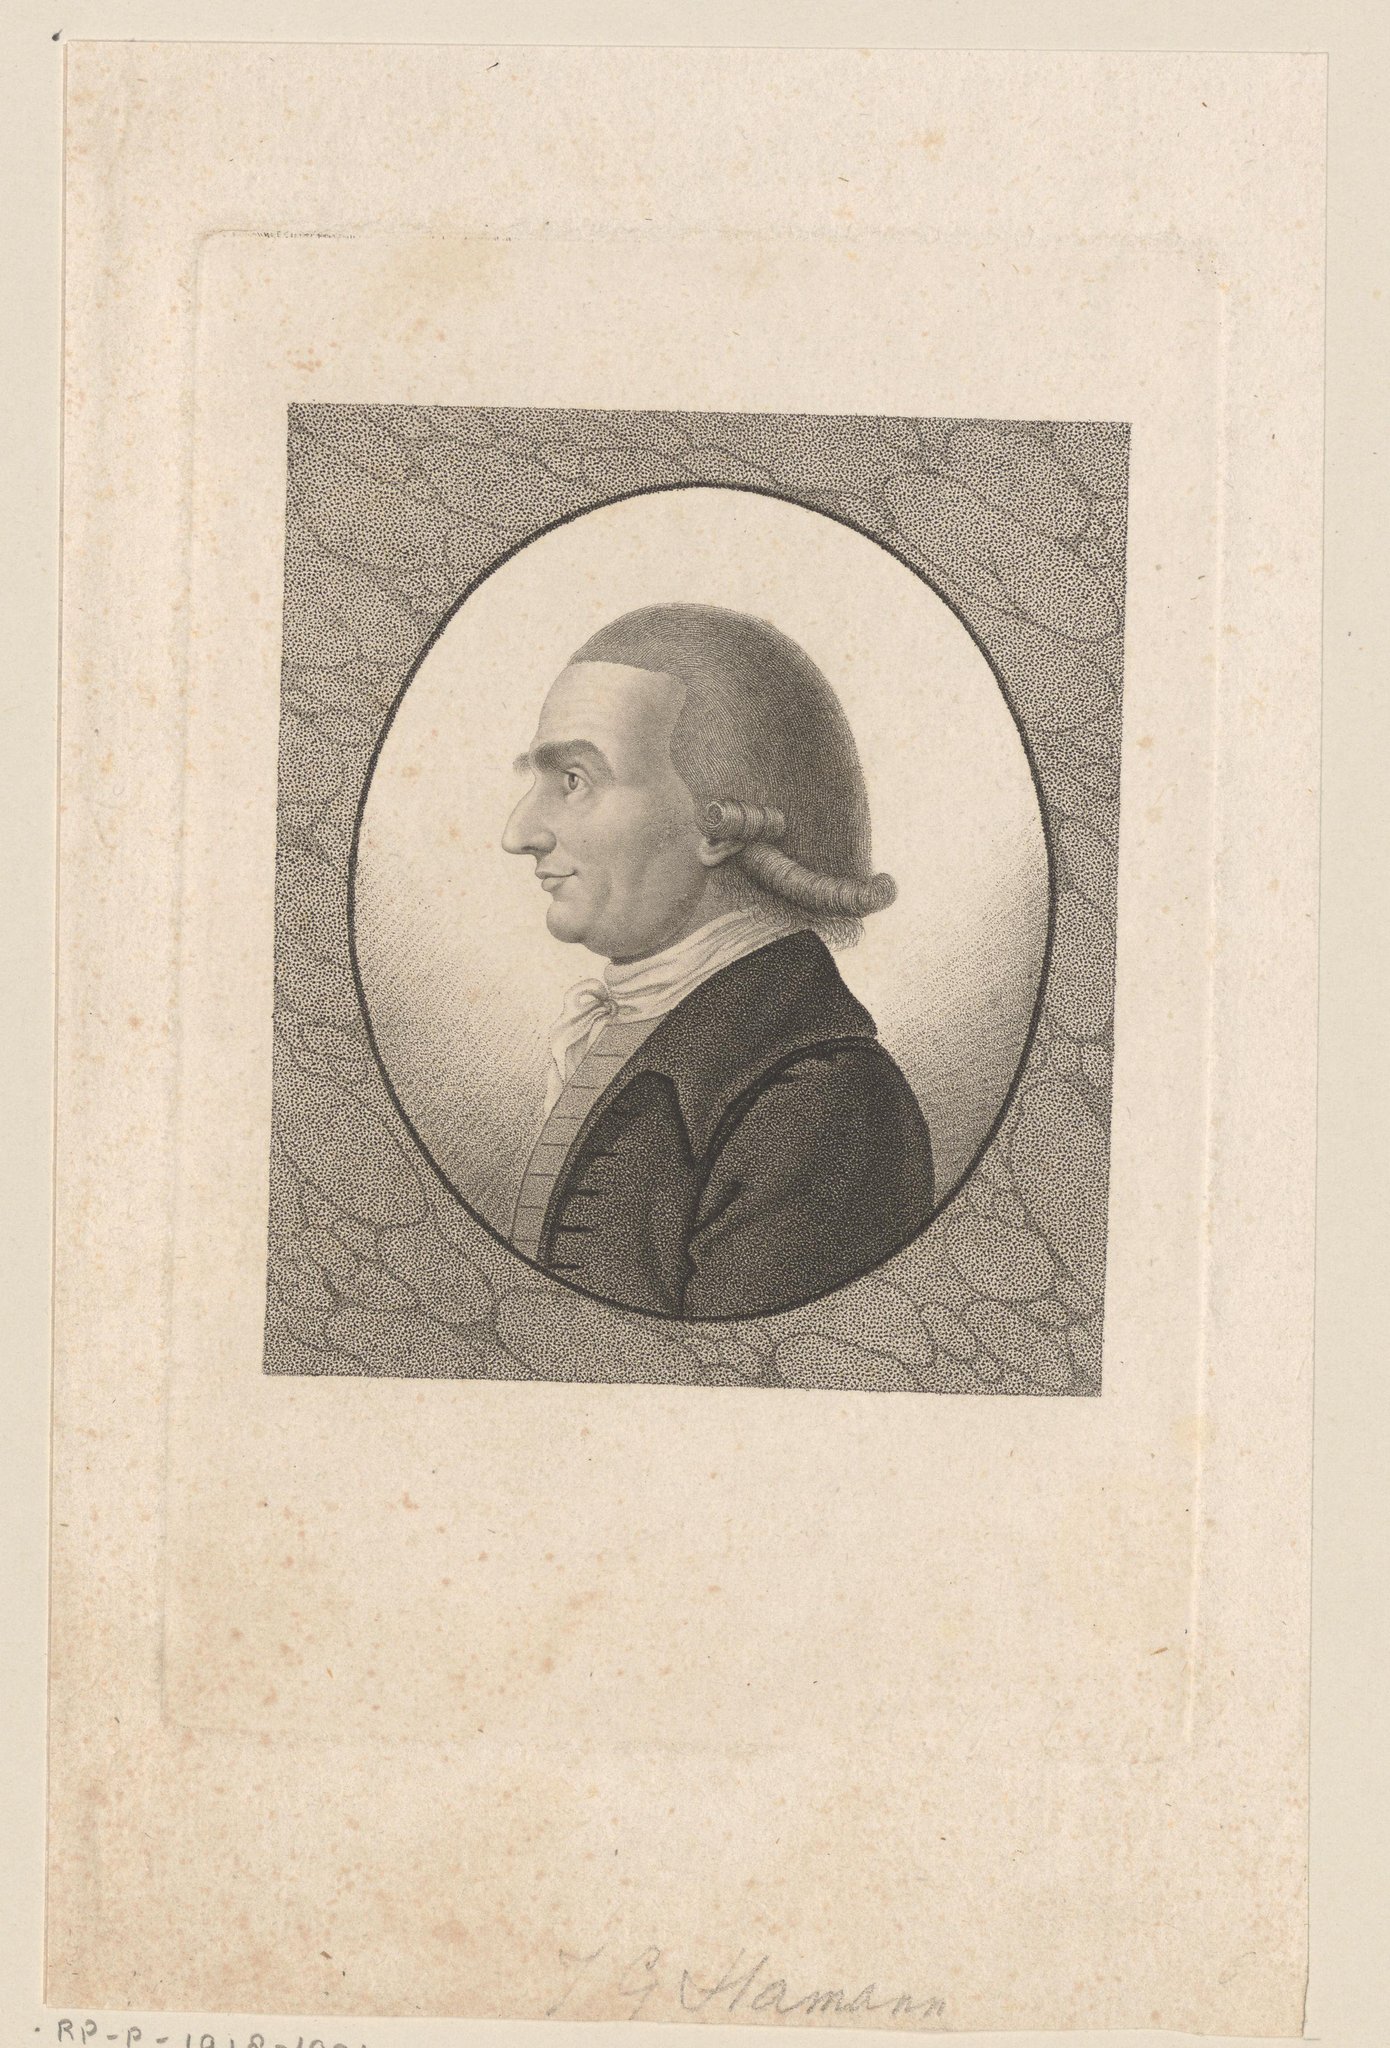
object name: print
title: Portret van Johann Georg Hamann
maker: Anonymous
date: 1760-1799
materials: paper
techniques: etching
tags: scholar, philosopher, historical persons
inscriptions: collector's mark: Lugt 2233